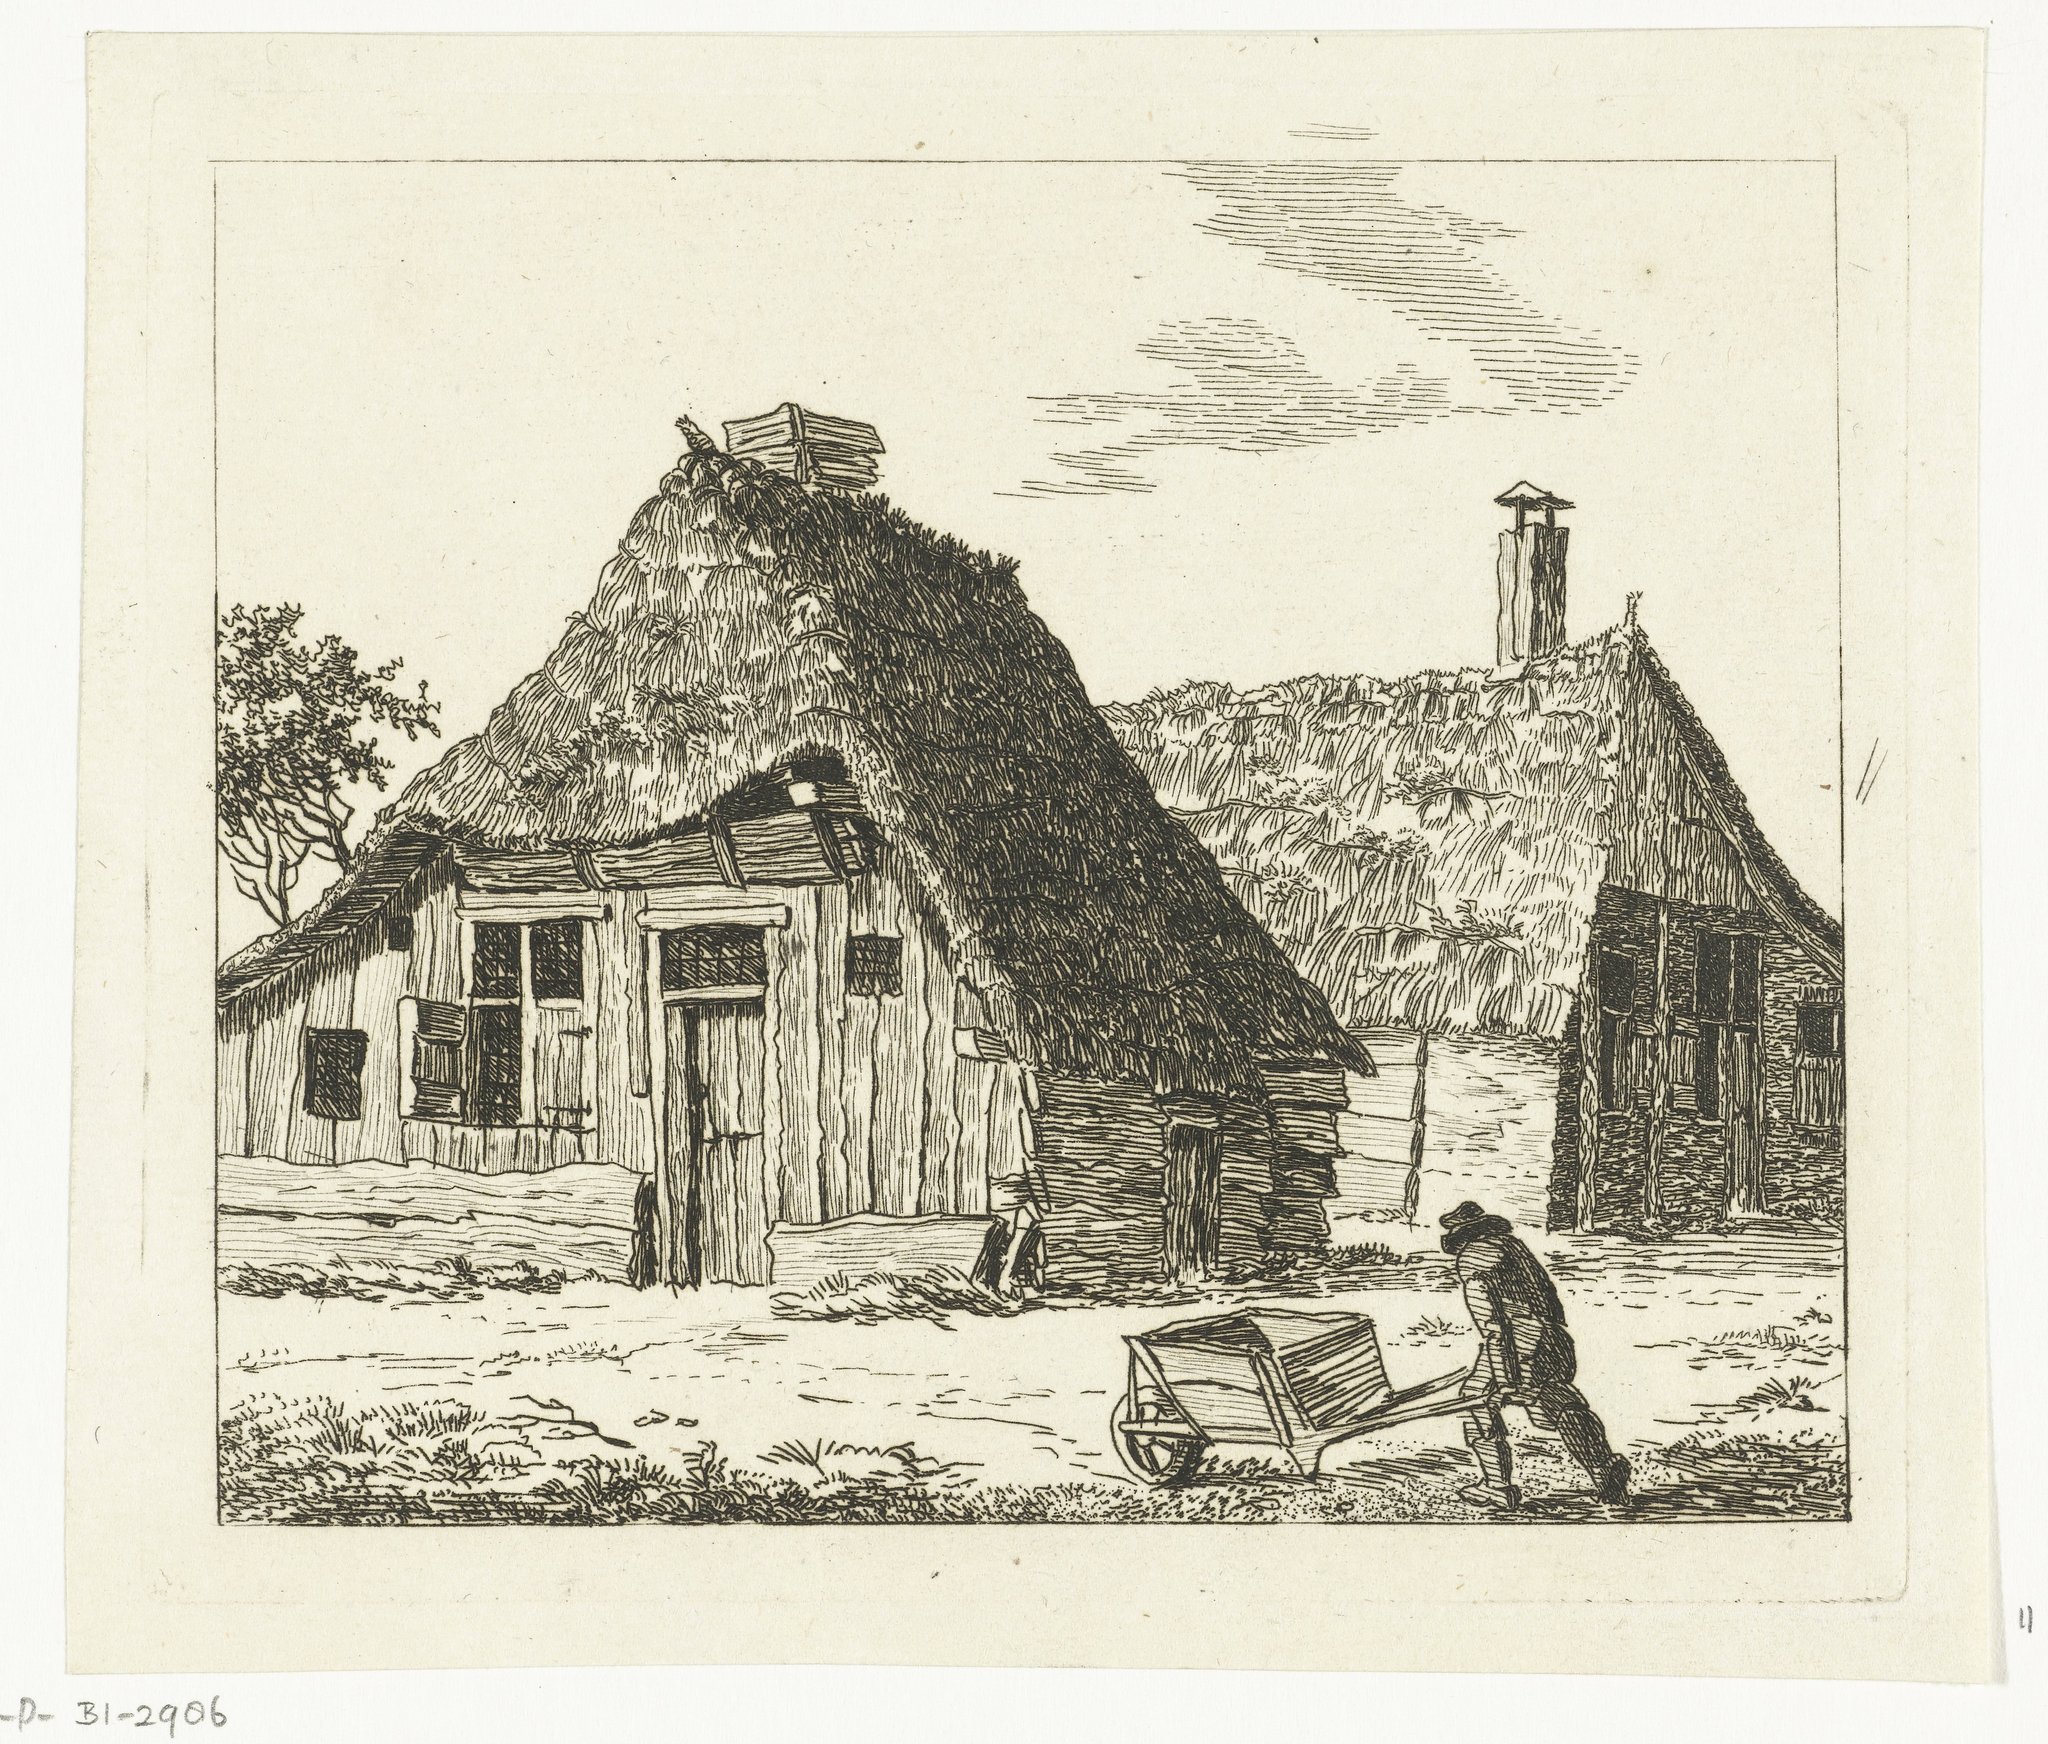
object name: print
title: Boerderijen te Rouveen bij Staphorst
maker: anthonie van den bos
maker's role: draughtsman, print maker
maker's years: 1763-1838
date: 1778-1838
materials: paper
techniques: etching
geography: netherlands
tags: farm (building)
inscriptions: collector's mark: Lugt 2228